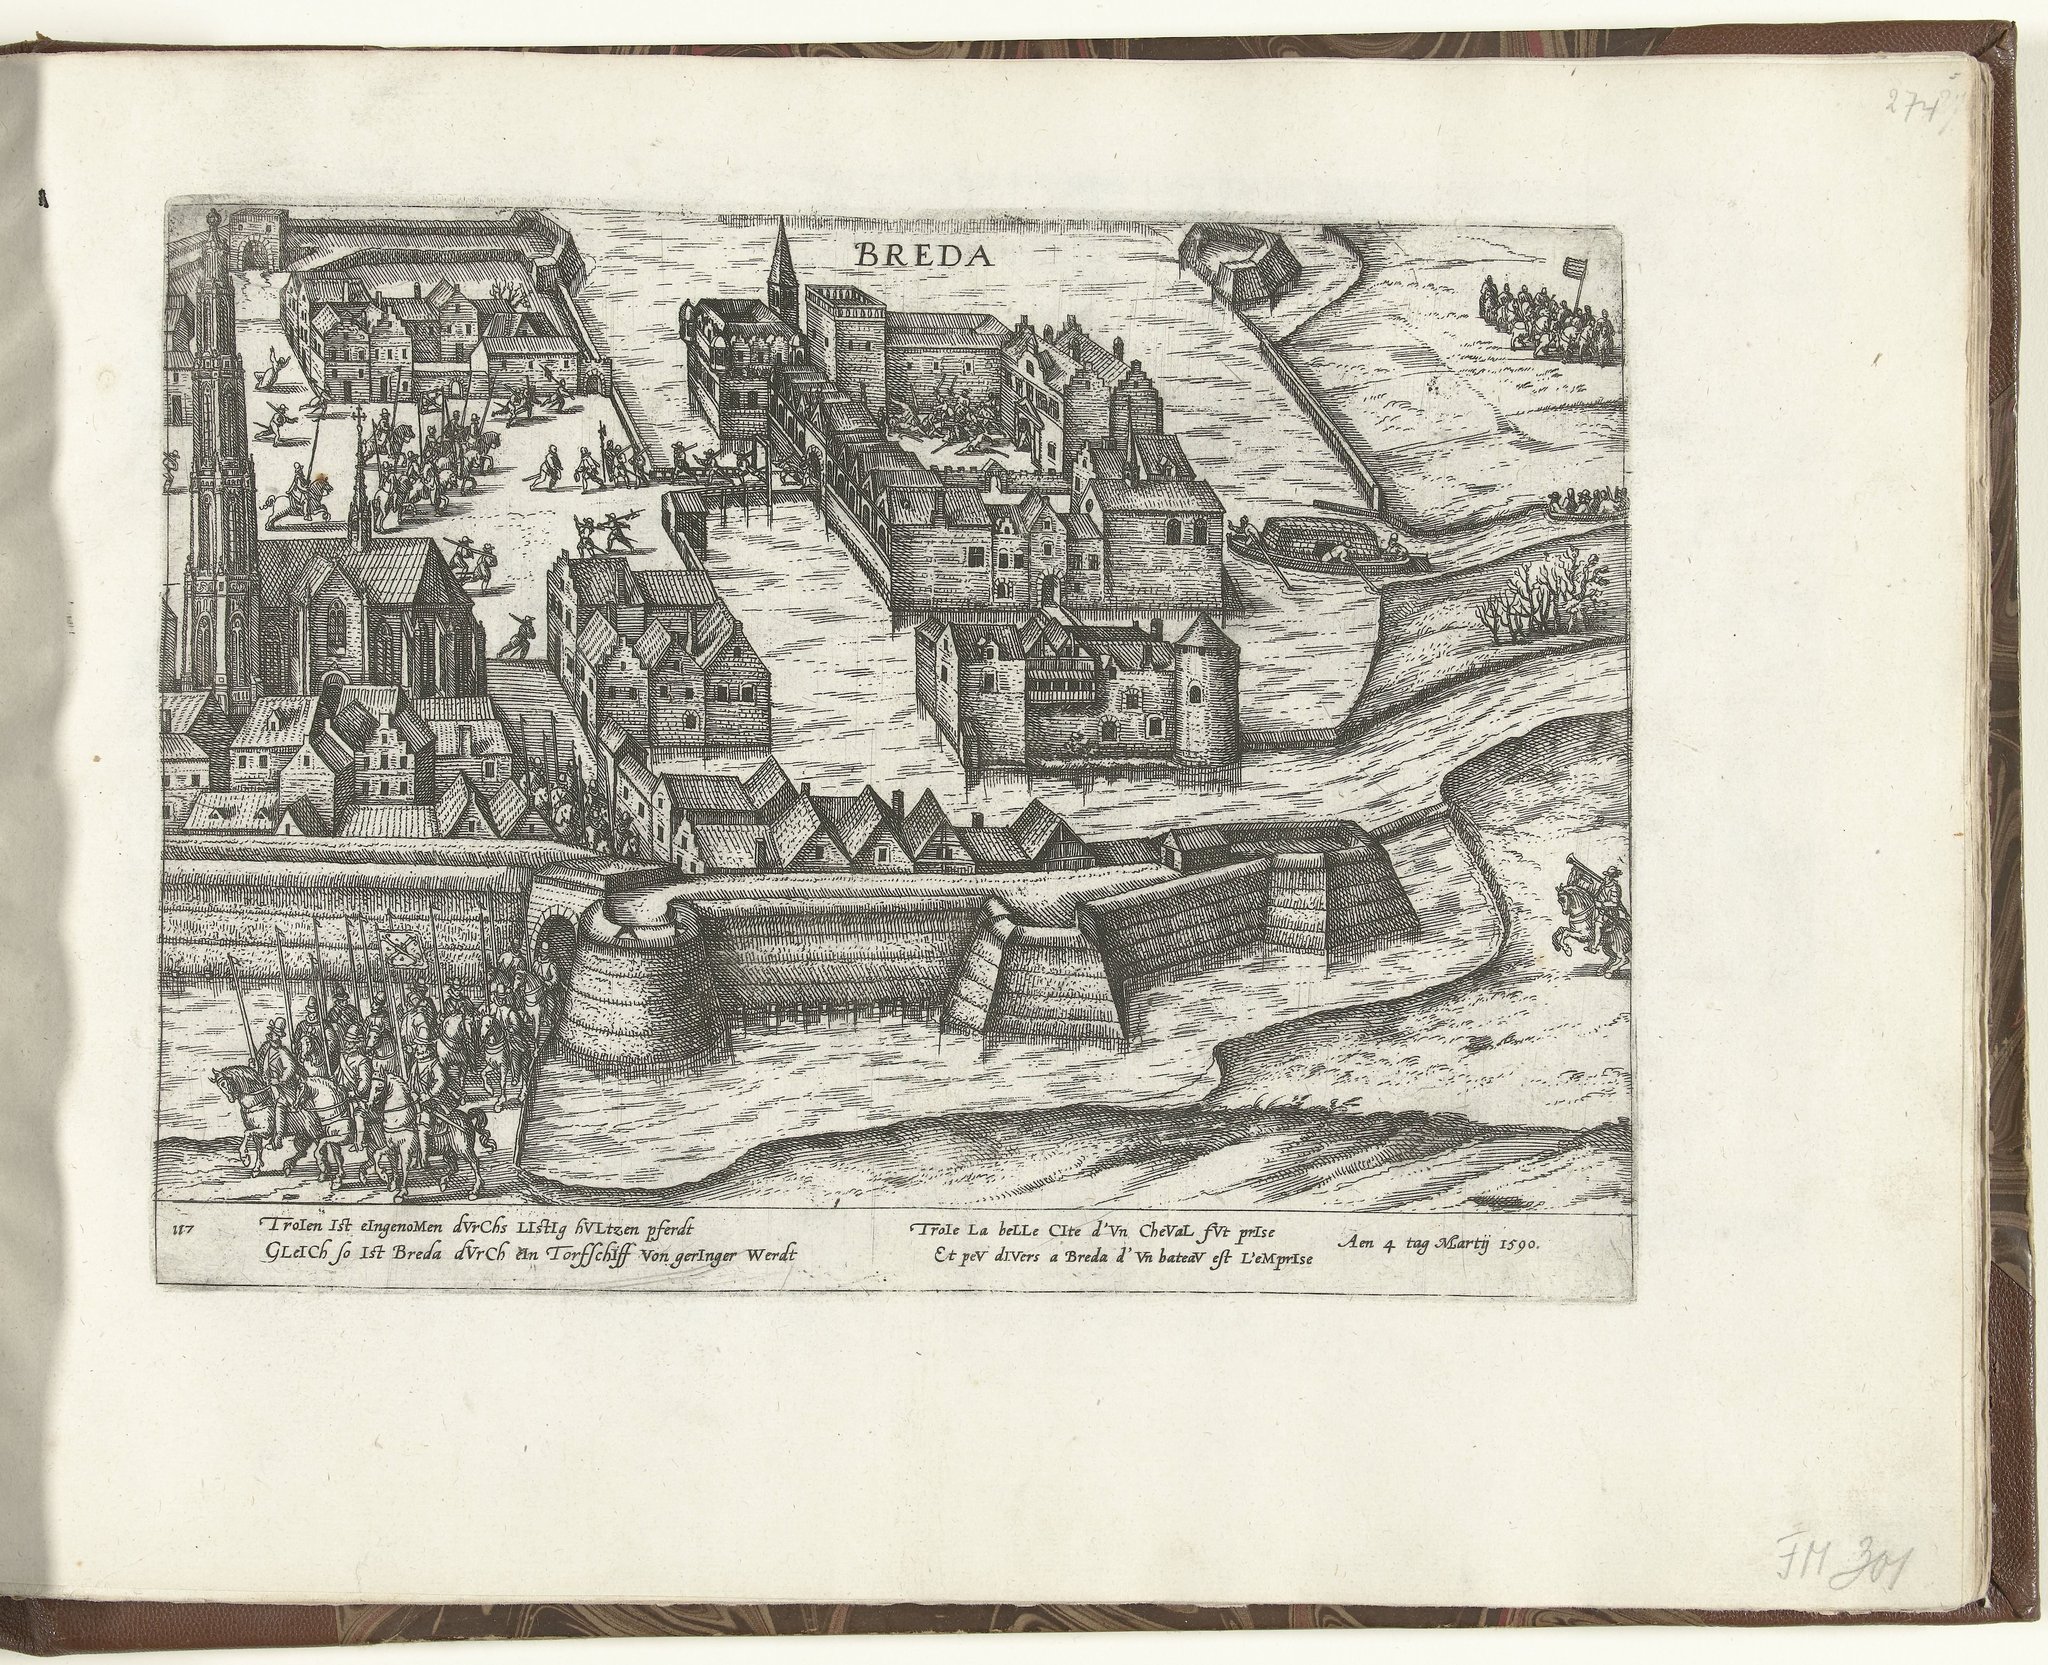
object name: album leaf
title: Serie 10: Nederlandse en Buitenlandse Gebeurtenissen, 1587-1612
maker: frans hogenberg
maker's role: print maker, publisher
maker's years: 1538-1590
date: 1590-1592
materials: paper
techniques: etching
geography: cologne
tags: capture of city (after the siege)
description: Het turfschip van Breda, 1590. Staatse soldaten overmeesteren het kasteel van Breda, 4 maart 1590. Met onderschrift van 2 regels in het Duits en 2 regels in het Frans. Genummerd: 117.